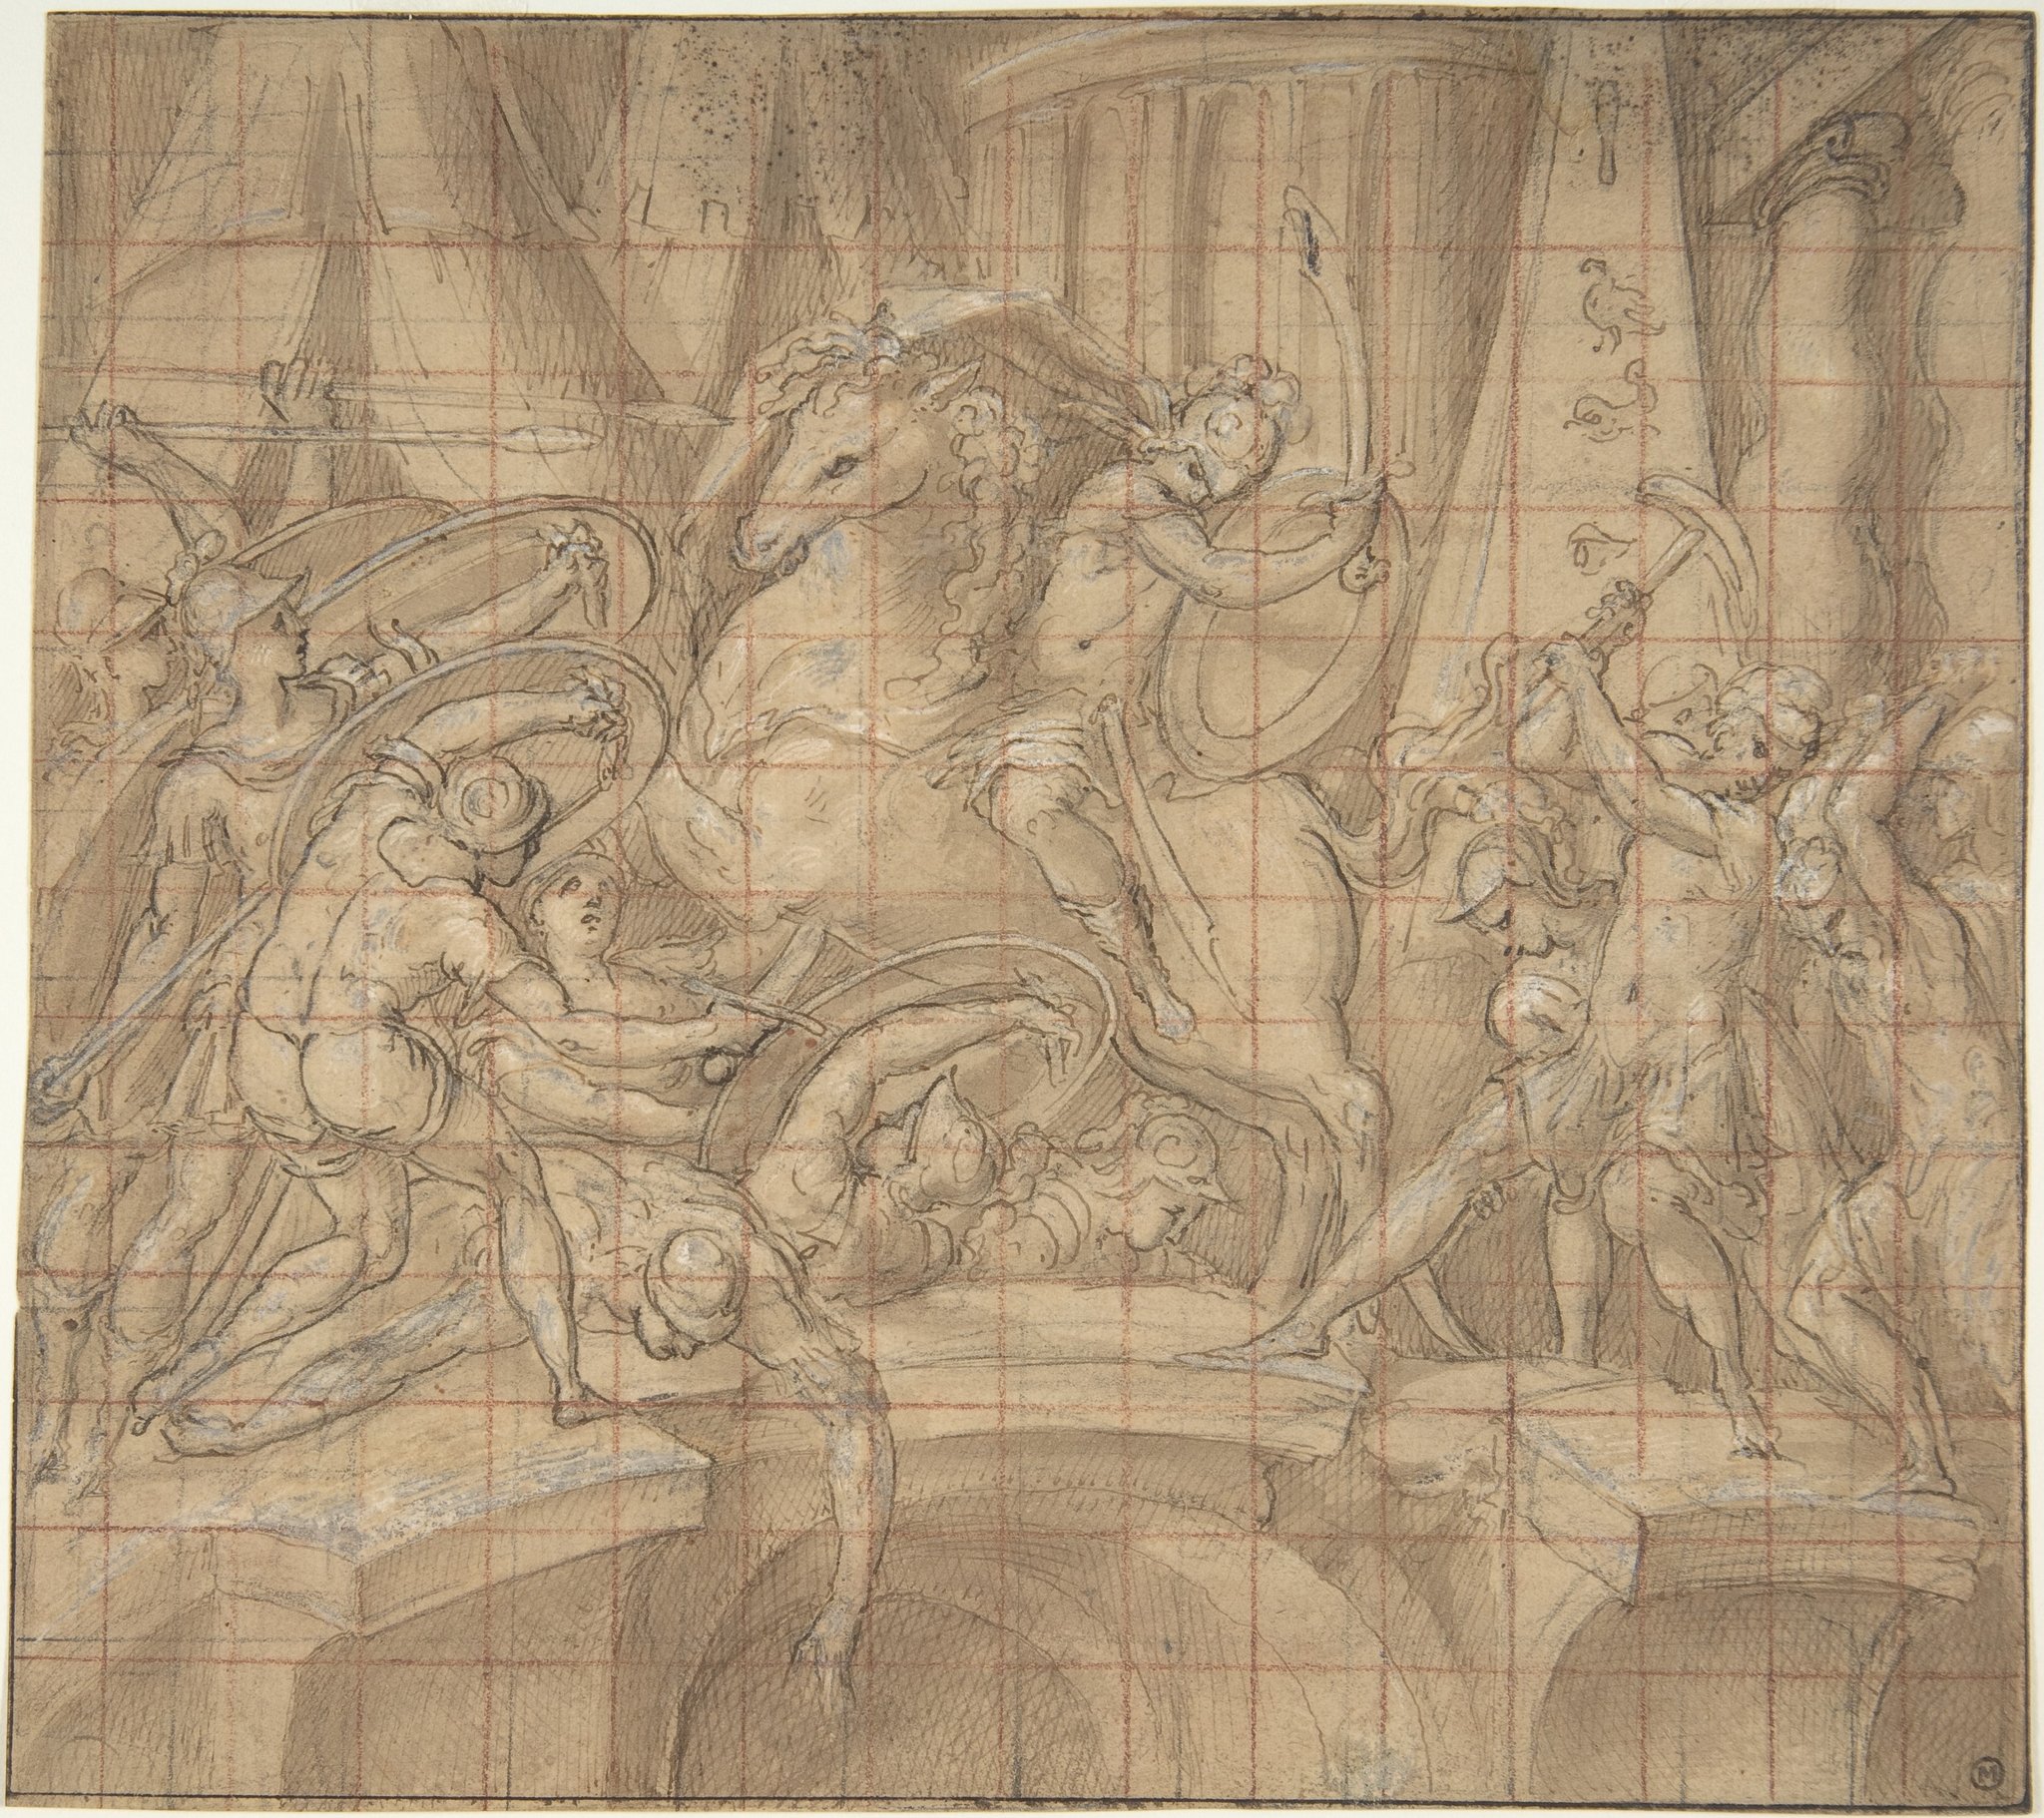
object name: drawing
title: Battle Scene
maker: anonymous, italian, 16th century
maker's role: artist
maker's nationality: italian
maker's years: 1550-1600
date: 1501-1600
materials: chalk, ink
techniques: highlighting, pen, drawing, wash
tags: battles,soldiers,spears,swords,horses